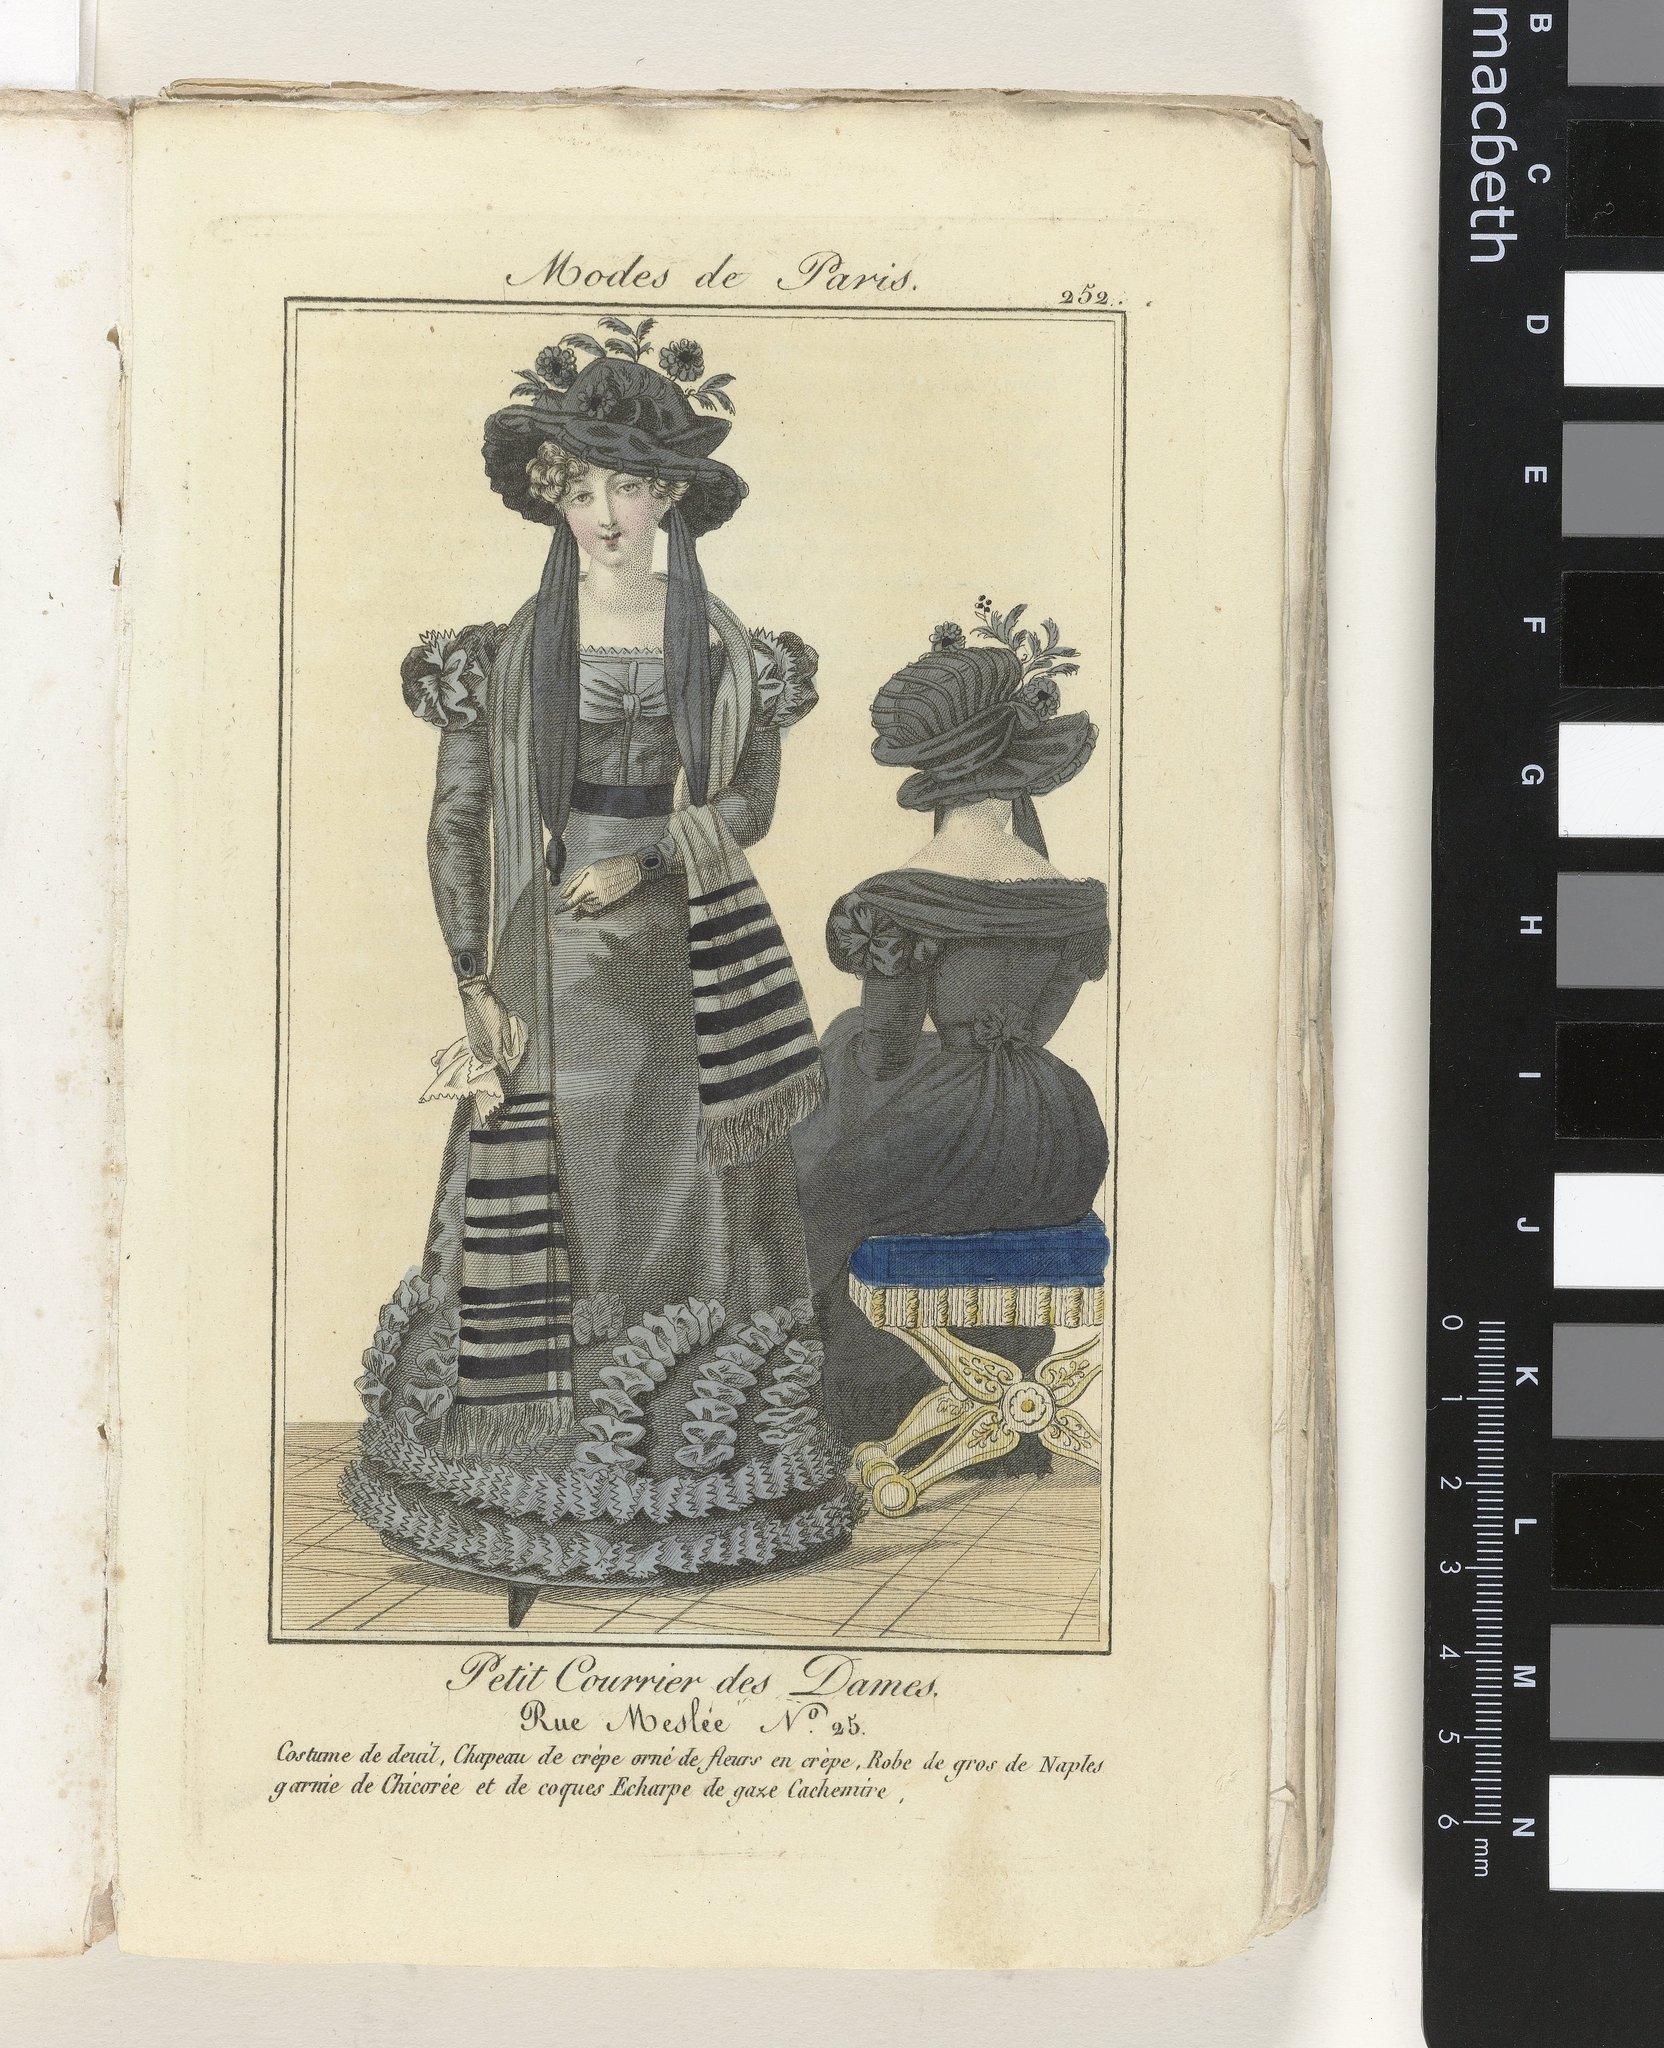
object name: fashion print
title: Petit Courrier des Dames, 1824 nr. 252: Costume de deuil...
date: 1824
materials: paper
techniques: engraving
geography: paris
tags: fashion plates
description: Prent uit het modetijdschrift Petit Courrier des Dames (1821-1868).